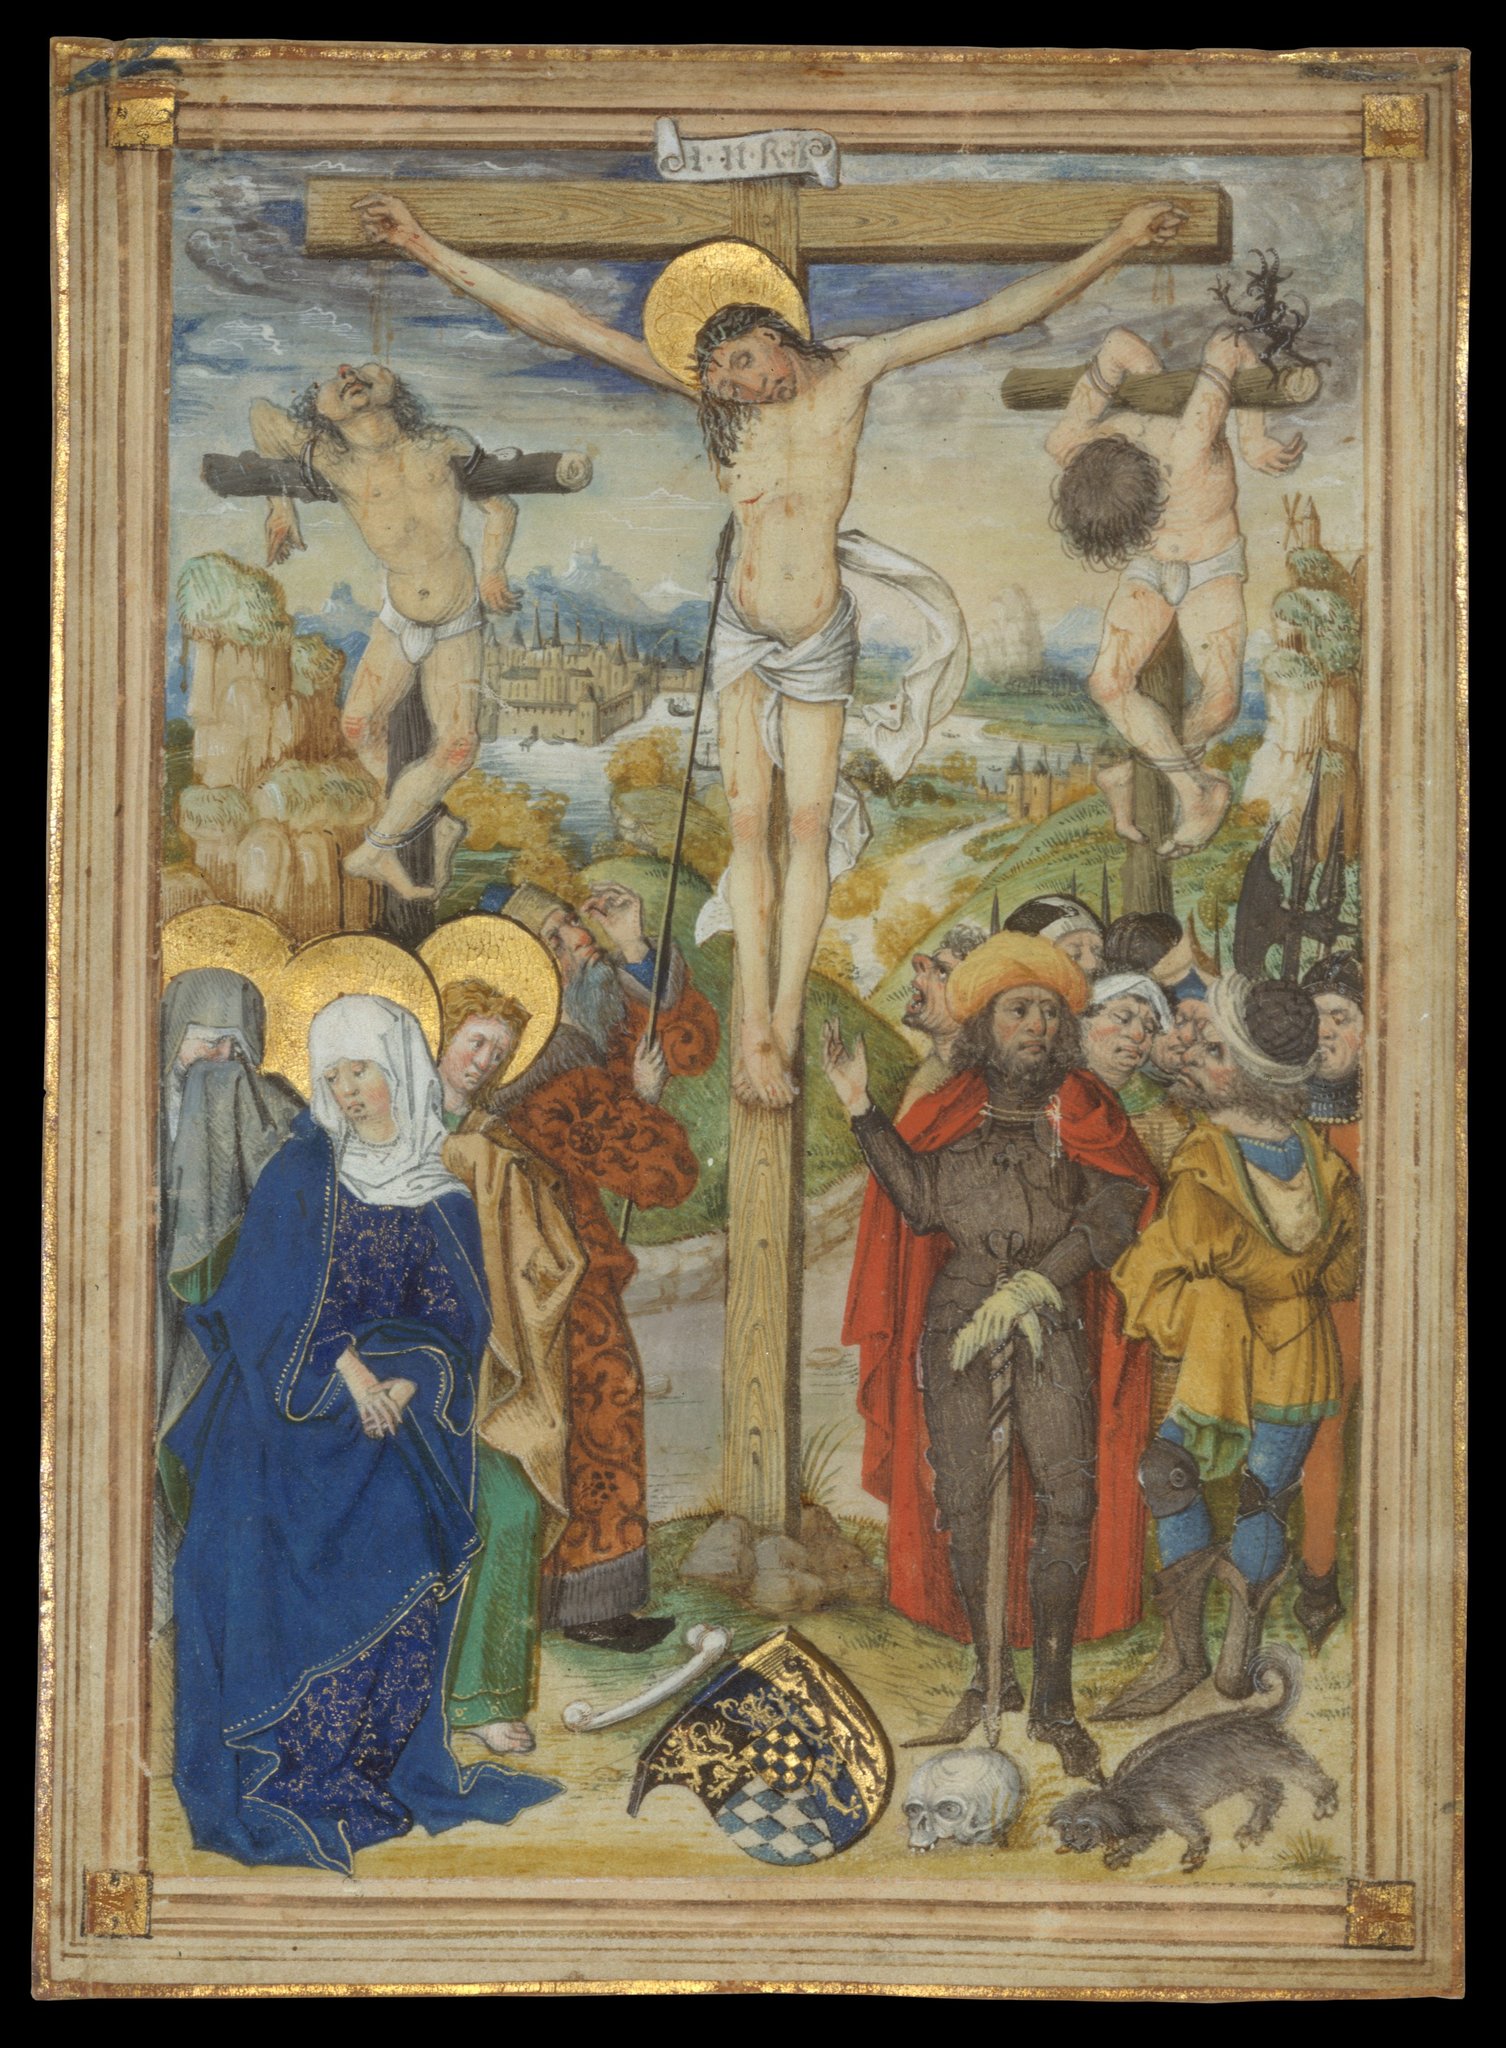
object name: leaf from a missal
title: The Crucifixion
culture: german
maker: housebook master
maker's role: artist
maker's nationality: german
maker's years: 1465-1500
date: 1481-1482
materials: parchment, paint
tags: skulls,dogs,christ,virgin mary,crucifixion